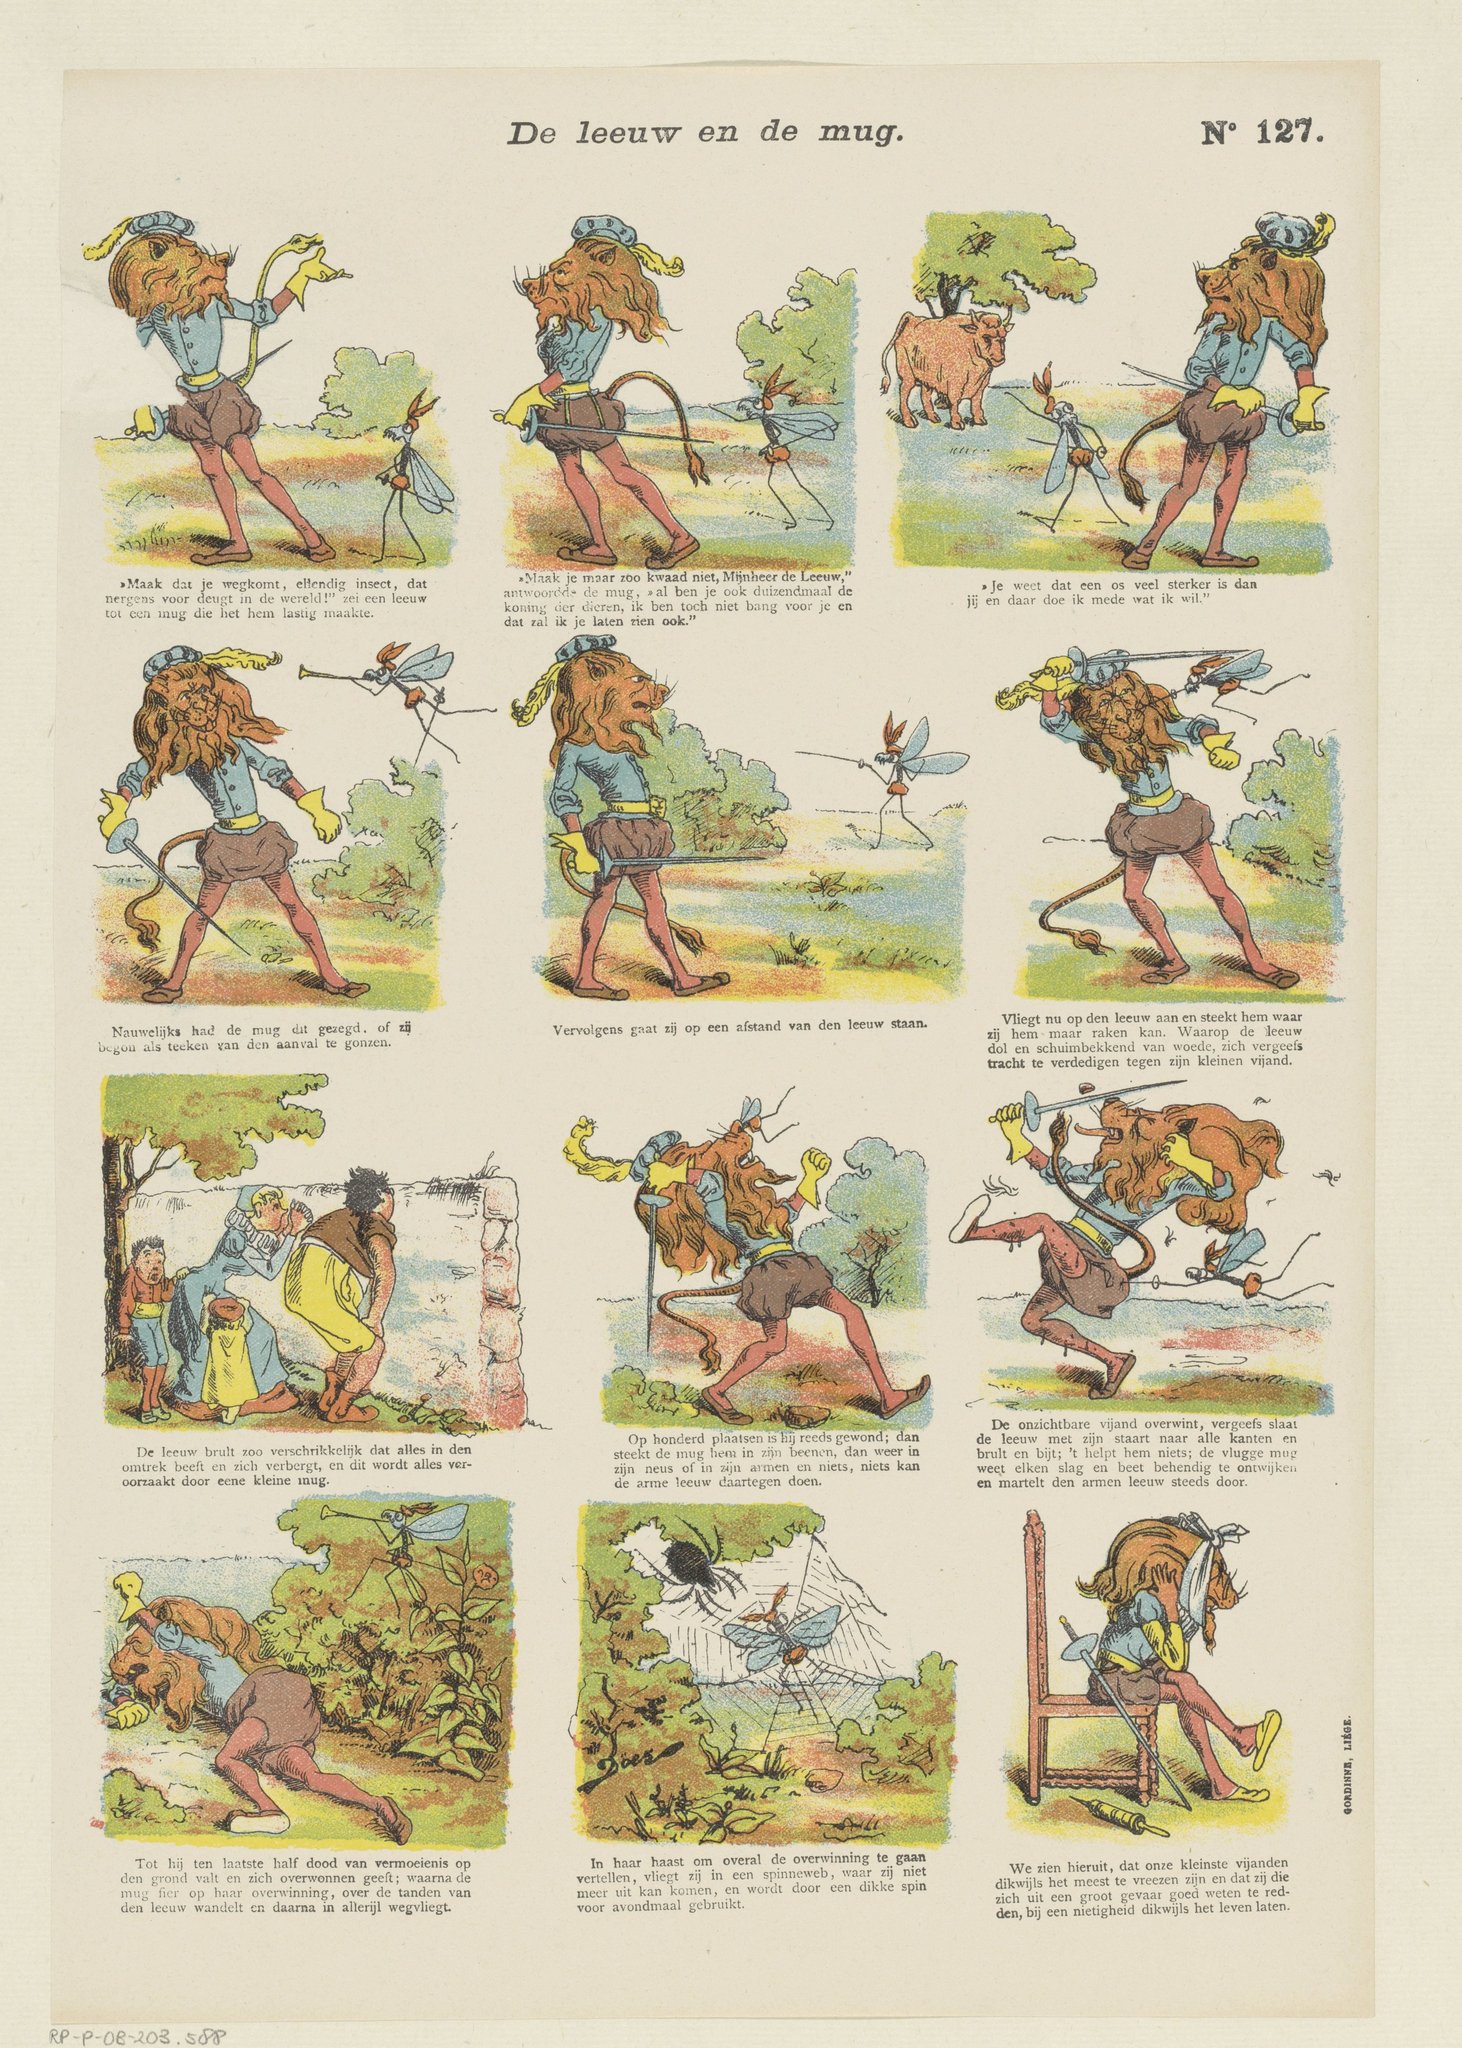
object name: print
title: De leeuw en de mug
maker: Anonymous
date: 1894-1959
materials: paper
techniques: lithograph, letterpress printing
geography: liège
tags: animals acting as human beings, fables, beasts of prey, predatory animals: lion, insects: mosquito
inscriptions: collector's mark: Lugt 2760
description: Blad met 12 voorstellingen over een leeuw die gestoken wordt door een mug. Onder elke afbeelding een onderschrift. Genummerd rechtsboven: No 127.